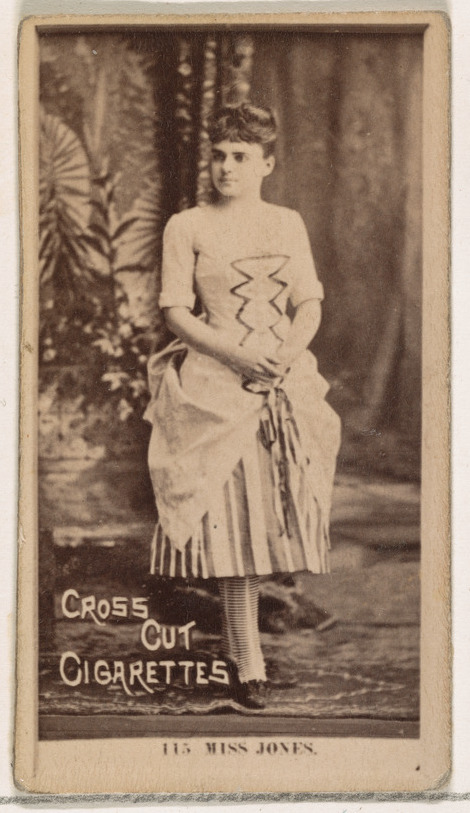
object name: print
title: Card Number 115, Miss Jones, from the Actors and Actresses series (N145-2) issued by Duke Sons & Co. to promote Cross Cut Cigarettes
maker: w. duke, sons & co.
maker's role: publisher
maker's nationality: american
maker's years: 1870-1920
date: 1880-1889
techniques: albumen silver print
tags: portraits,women,actresses